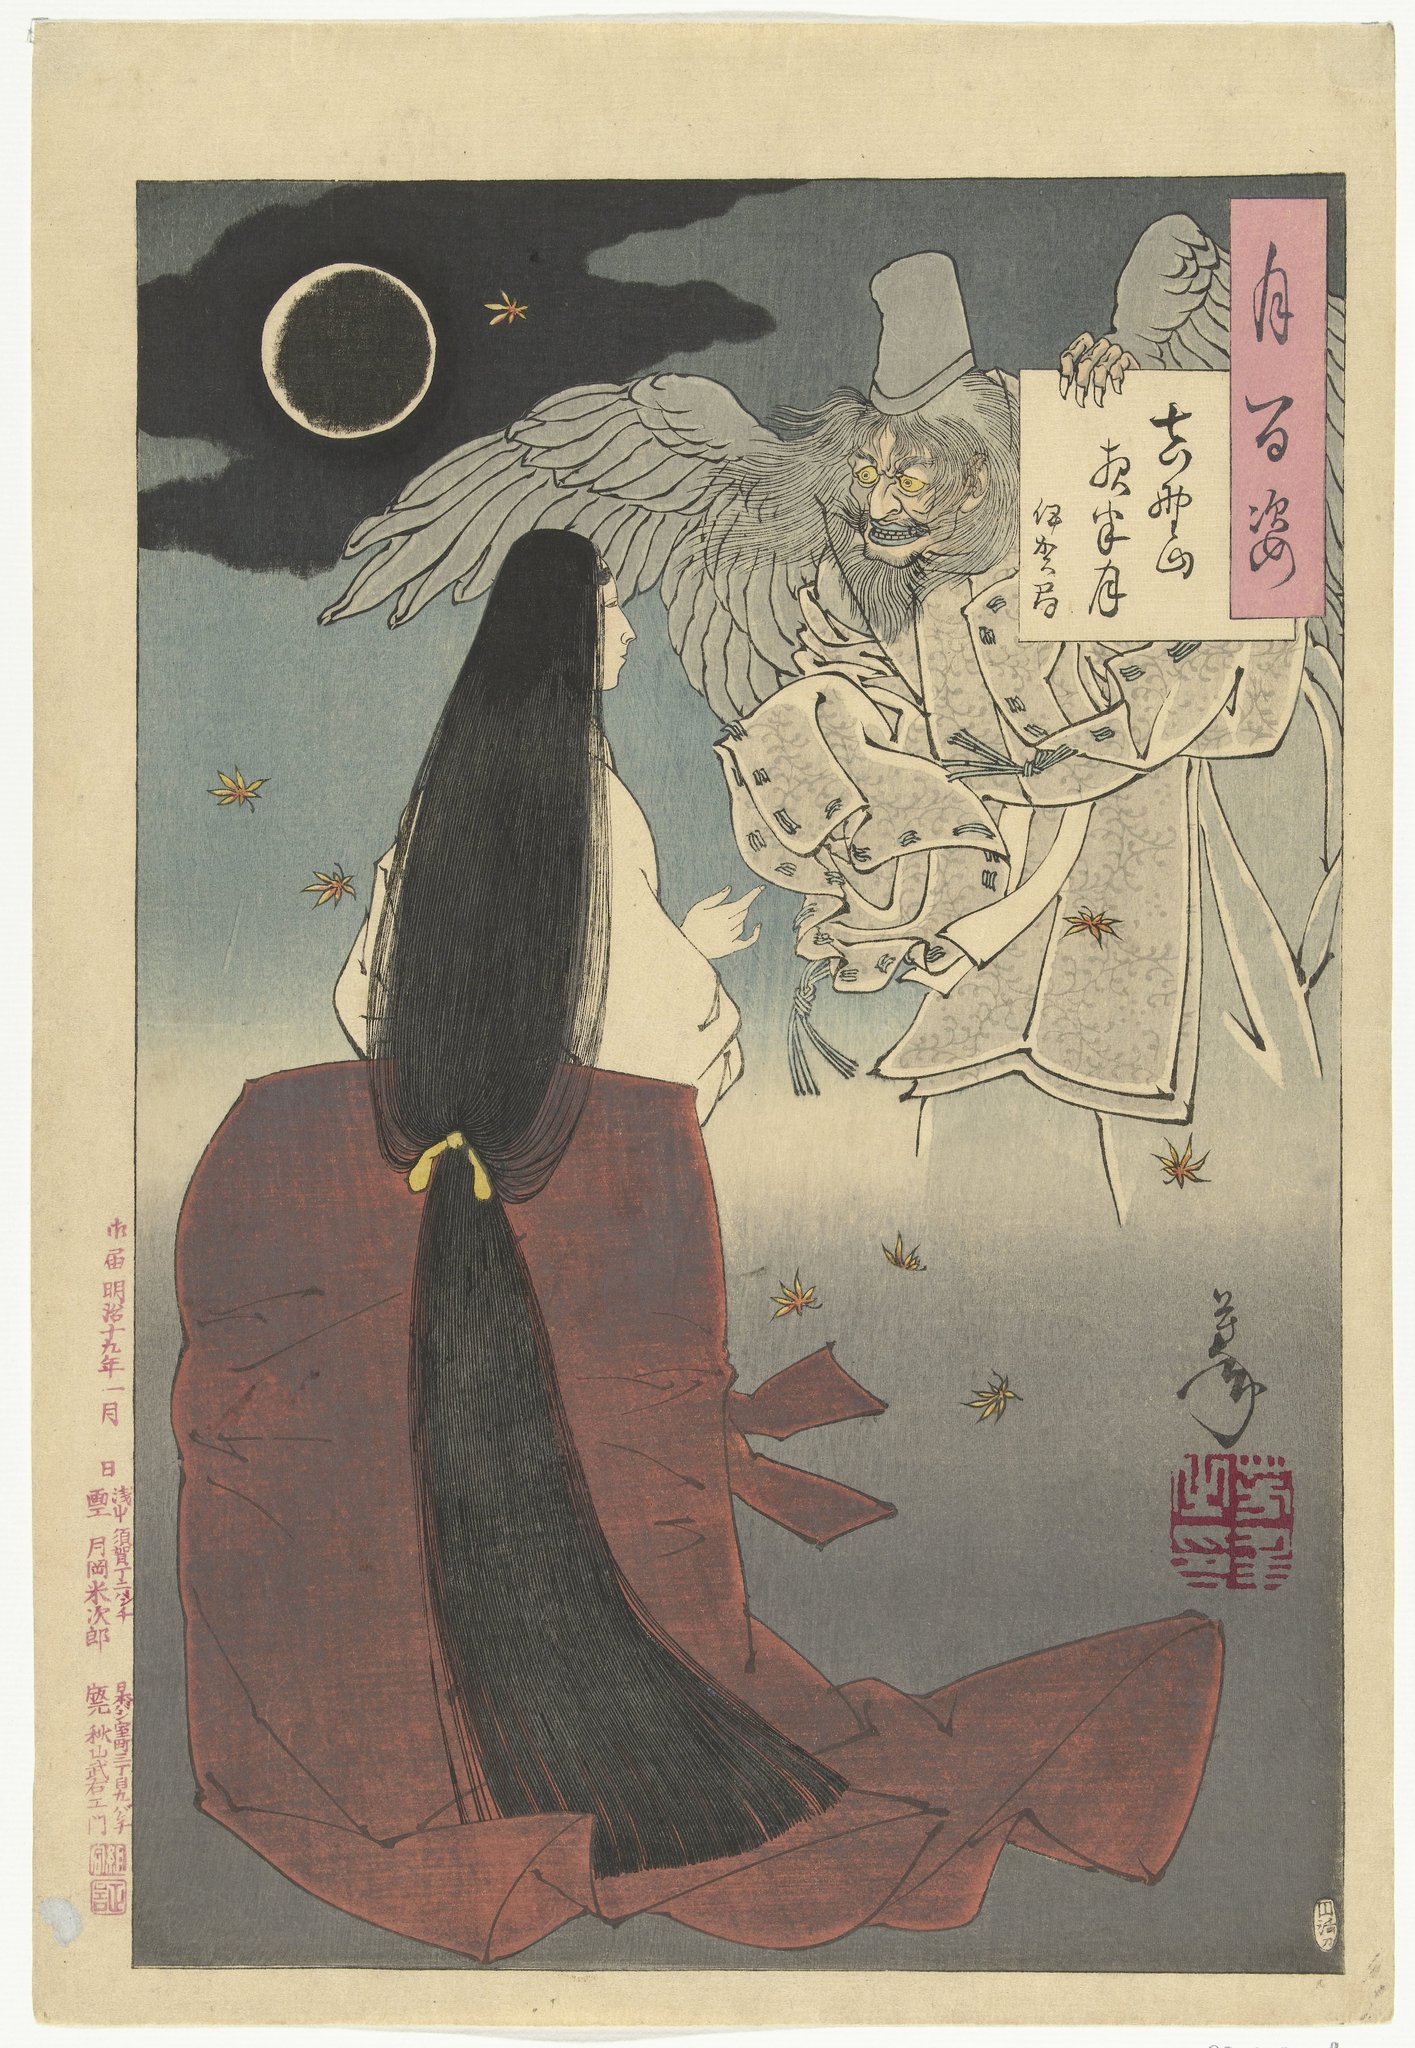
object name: print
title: Tsuki hyakushi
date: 1801-1886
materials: paper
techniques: woodcut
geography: japan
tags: adult woman, spirit, ghost, moon as celestial body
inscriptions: date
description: Vrouw met zeer lang haar, op de rug gezien: Iga no Tsubone, tegenover de gevleugelde geest van Kiyotaka, de klauwachtige hand over het vierkanten cartouche houdend; op de achtergrond een volle maan, waarvoor een donkere wolk, en vallende herfstblaadjes.